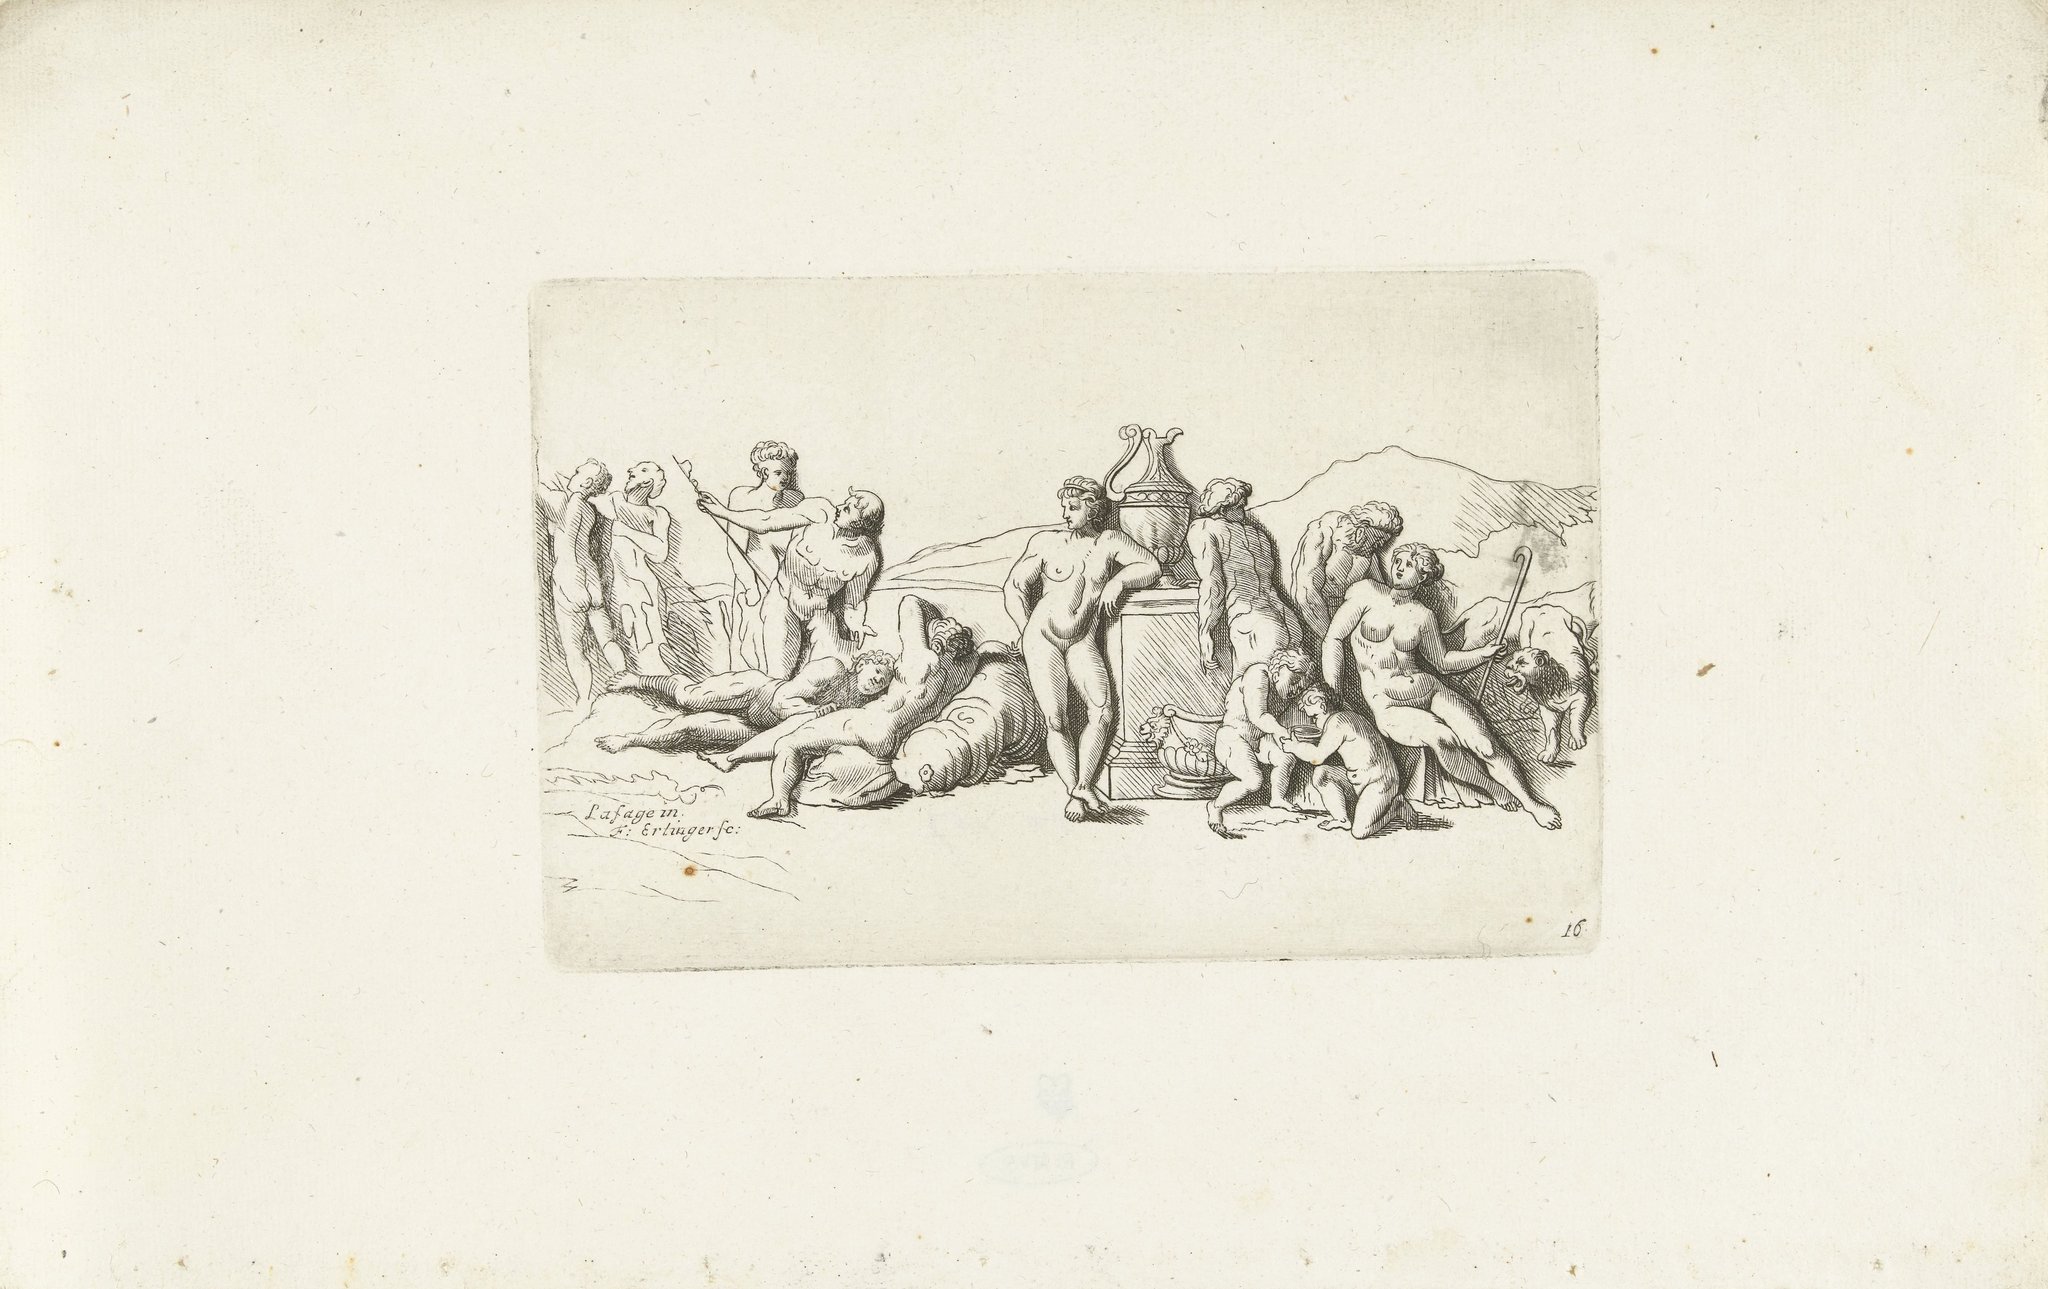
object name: print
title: Bacchanten met wijnkruik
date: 1652-1707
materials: paper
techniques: engraving, etching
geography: netherlands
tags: veneration of bacchus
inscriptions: collector's mark: Lugt 2228, collector's mark: Lugt 2760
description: Een groep naakte personen aan weerszijden van een pilaar met een grote wijnkruik.